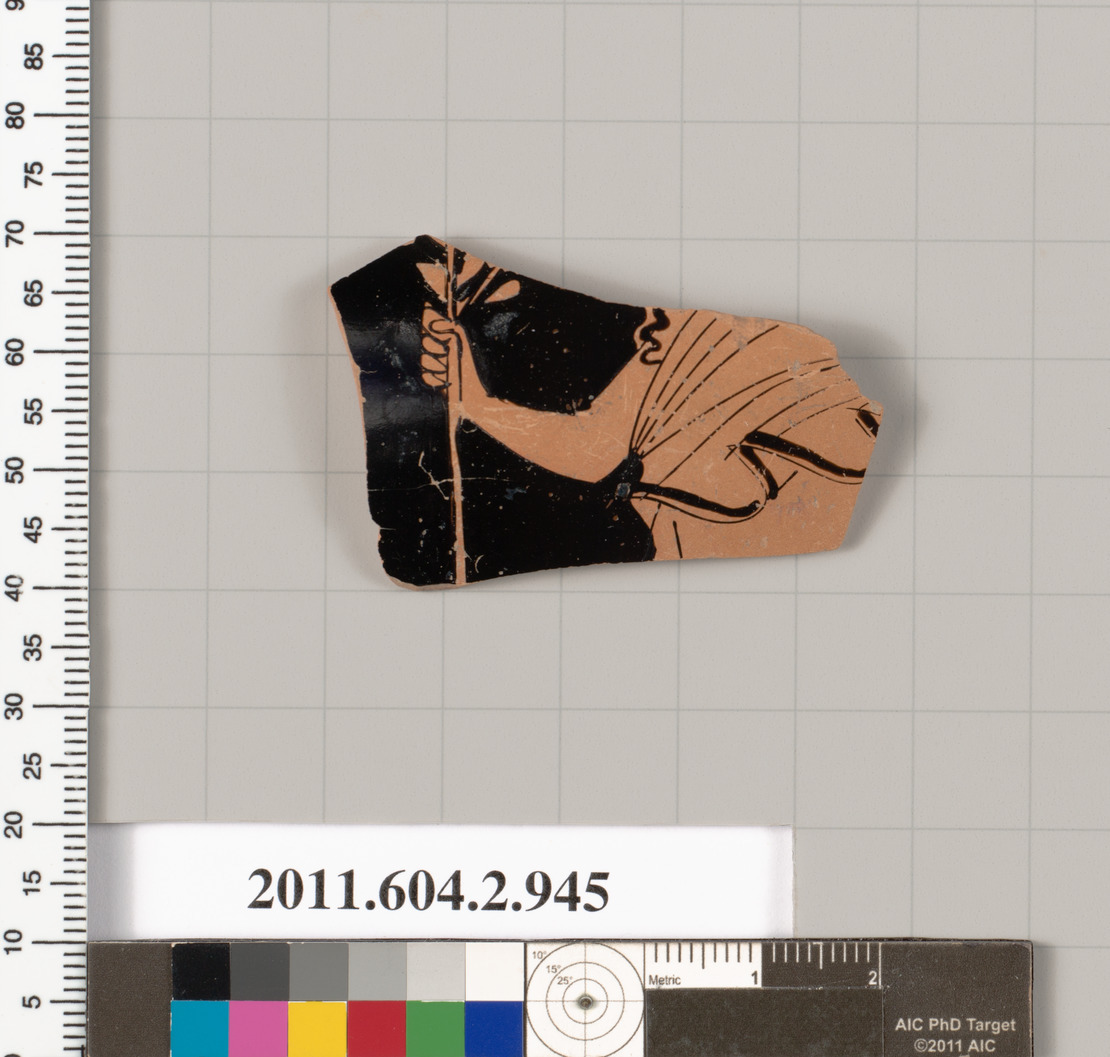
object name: oinochoe fragment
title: Terracotta fragment of an oinochoe (jug)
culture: greek, attic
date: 460-440 BCE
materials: terracotta